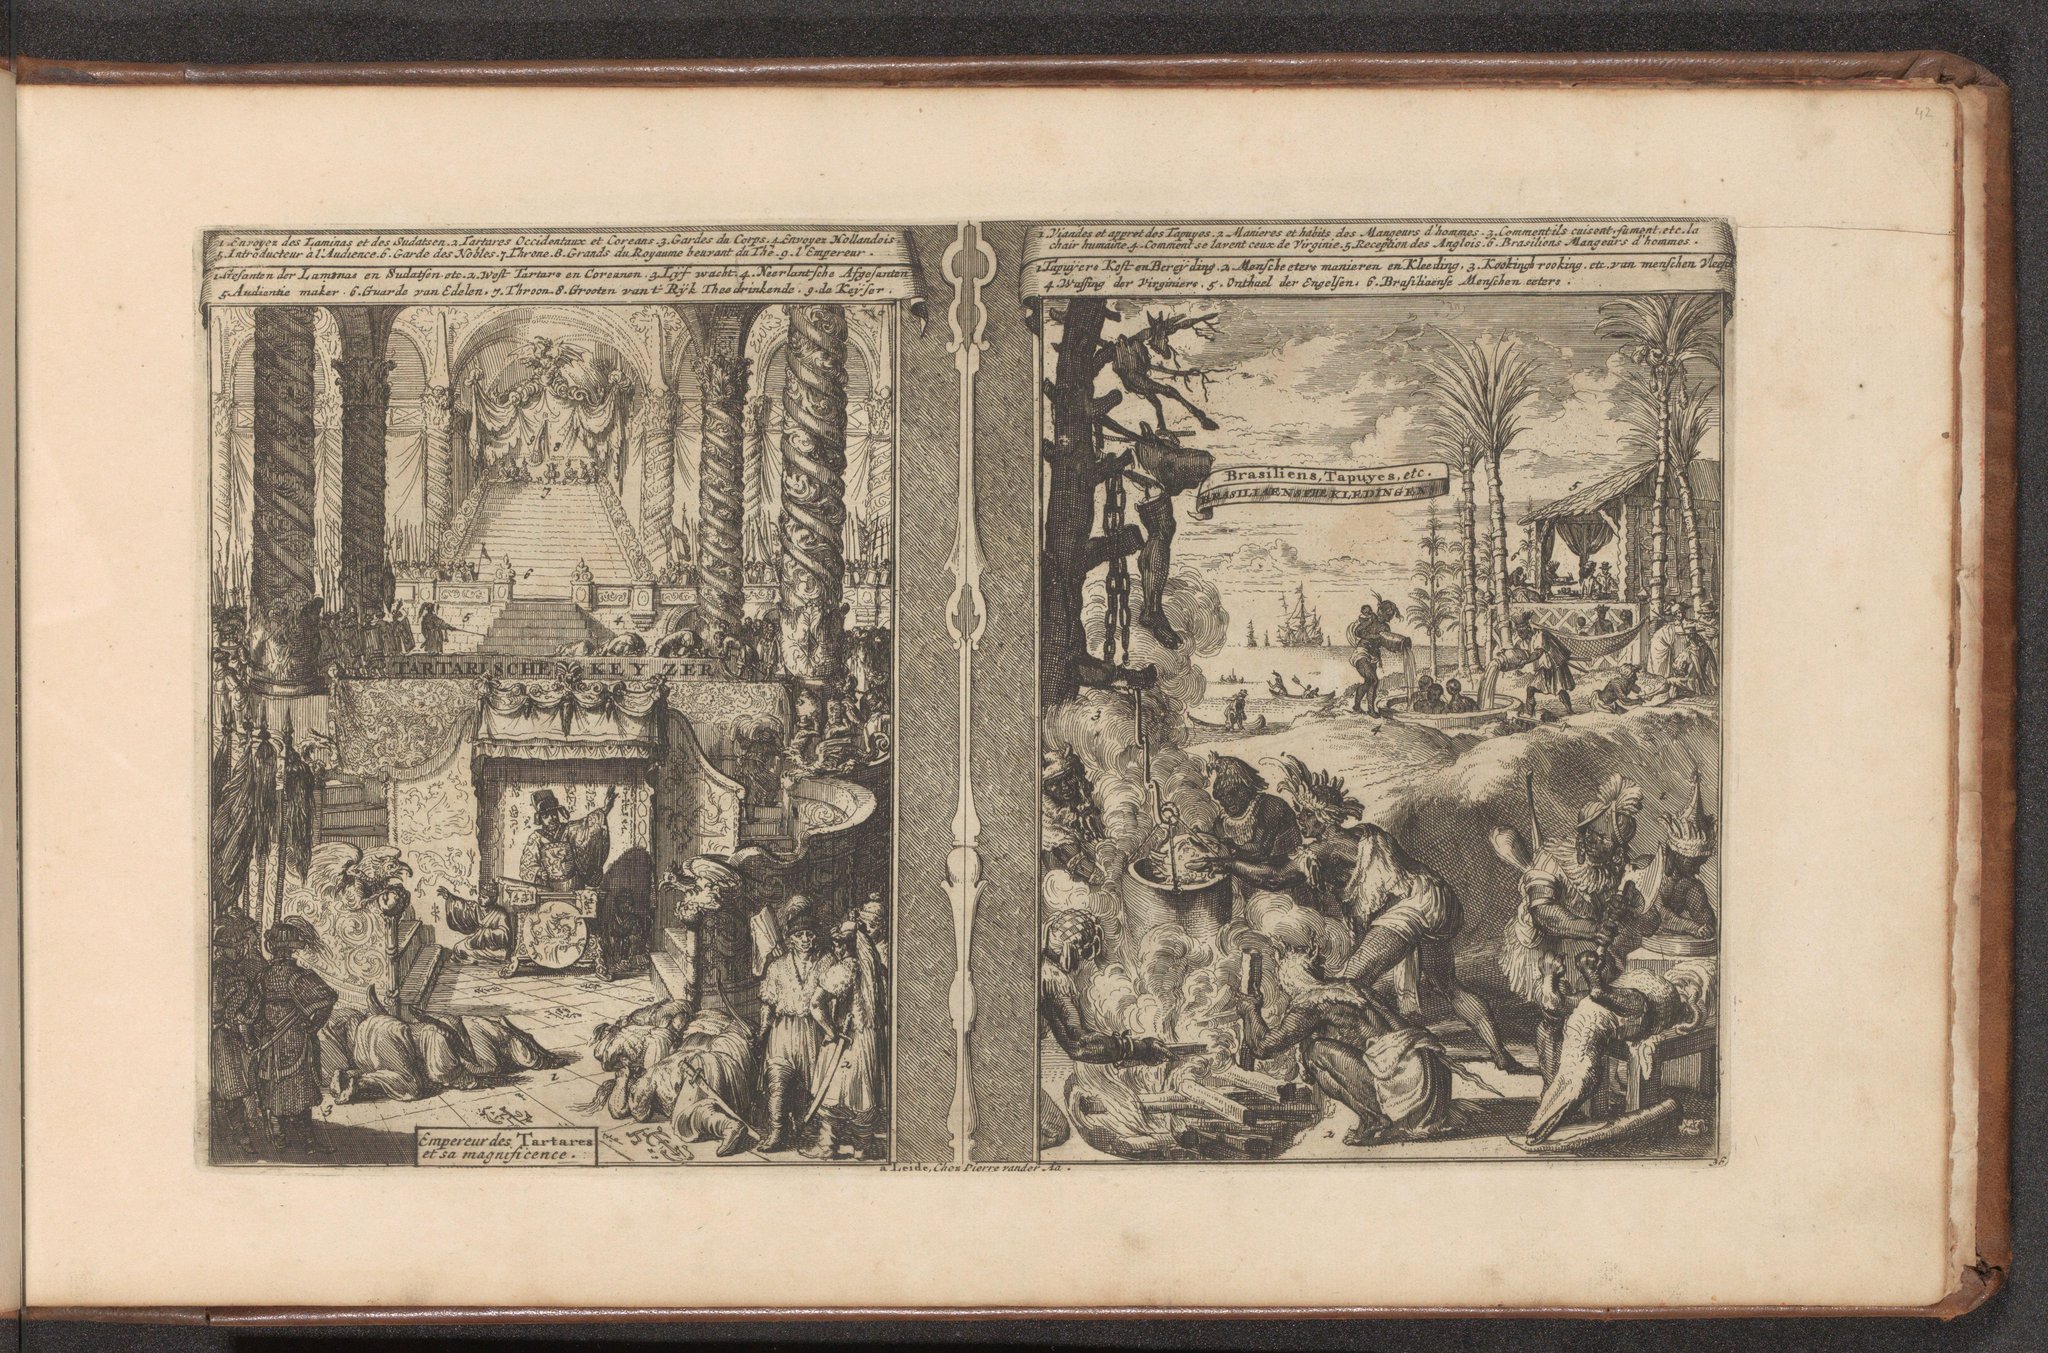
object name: album leaf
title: Les Indes Orientales et Occidentales et autres lieux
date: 1682-1733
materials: paper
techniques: etching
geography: leiden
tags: crocodiles: crocodile, royal household; courtiers, retinue, train, cannibalism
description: Voorstelling in twee delen. Aan de linkerzijde het hof van de Tartaarse keizer. Tussen de vier pilaren knielen enkele Nederlandse gezanten om audiëntie te krijgen bij de keizer. Die keizer bevindt zich bovenaan de trap achter een gordijn. Op de rechter voorstelling bereiden enkele Braziliaanse Tapoeiers hun voedsel. De Tapoeiers stonden bekend om hun kannibalistische trekjes, vandaar de ledematen van menselijke slachtoffers in de bomen. Daarnaast slachten twee Tapoeiers een krokodil. Met een legenda in het Nederlands en het Frans. De prent maakt deel uit van een album.